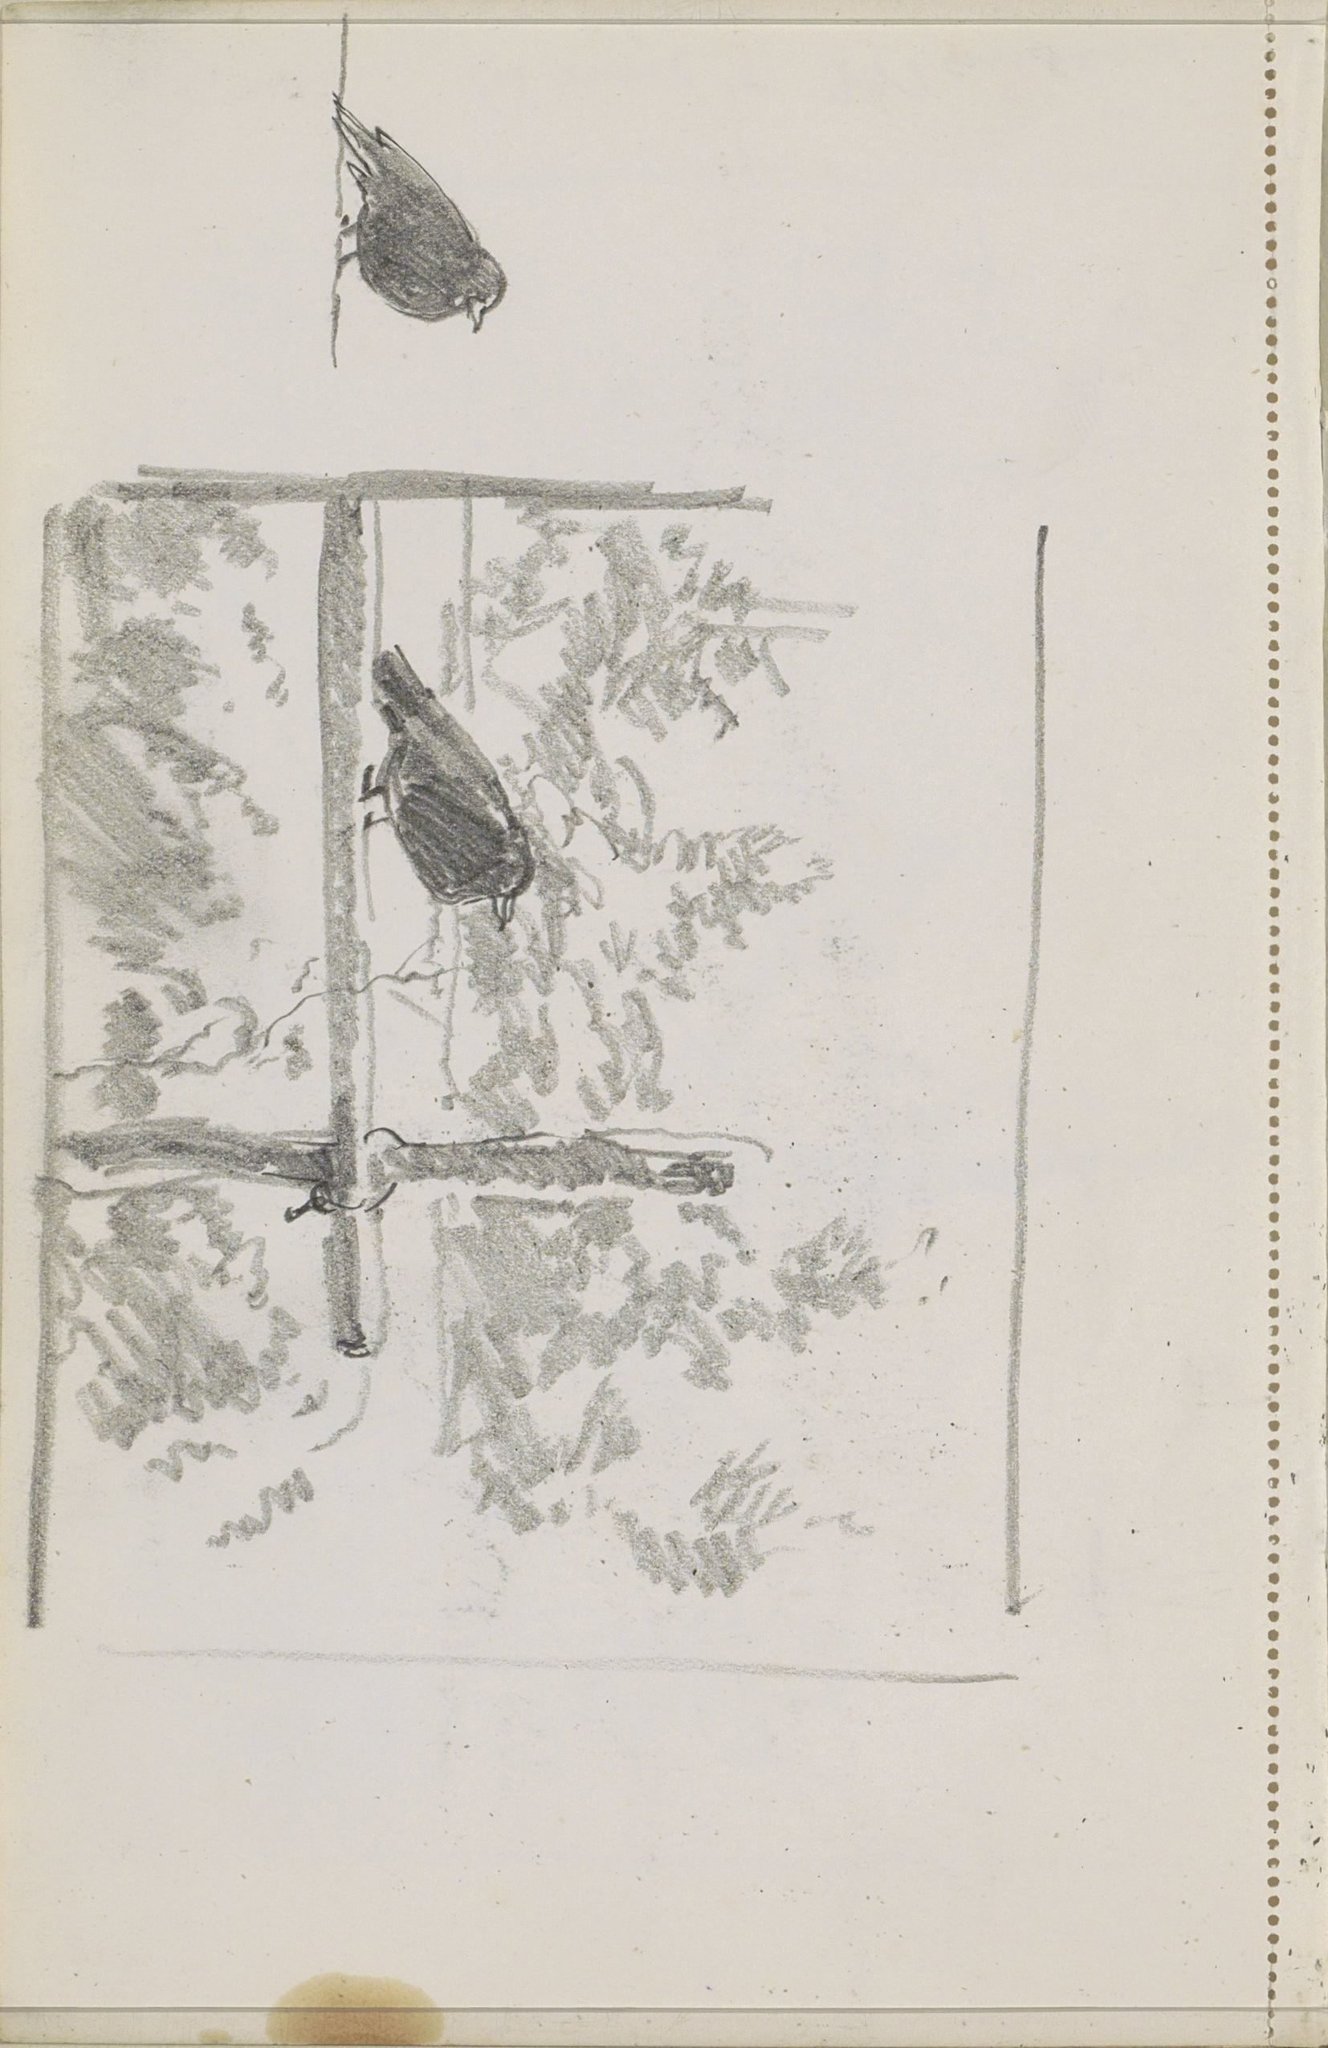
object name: sketchbook leaf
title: Vogel op een houten hek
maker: cornelis vreedenburgh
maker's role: draughtsman, print maker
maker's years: 1880-1946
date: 1890-1946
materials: paper, pencil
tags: birds, fence, wall, paling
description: Blad 23 verso uit een schetsboek met 53 bladen.